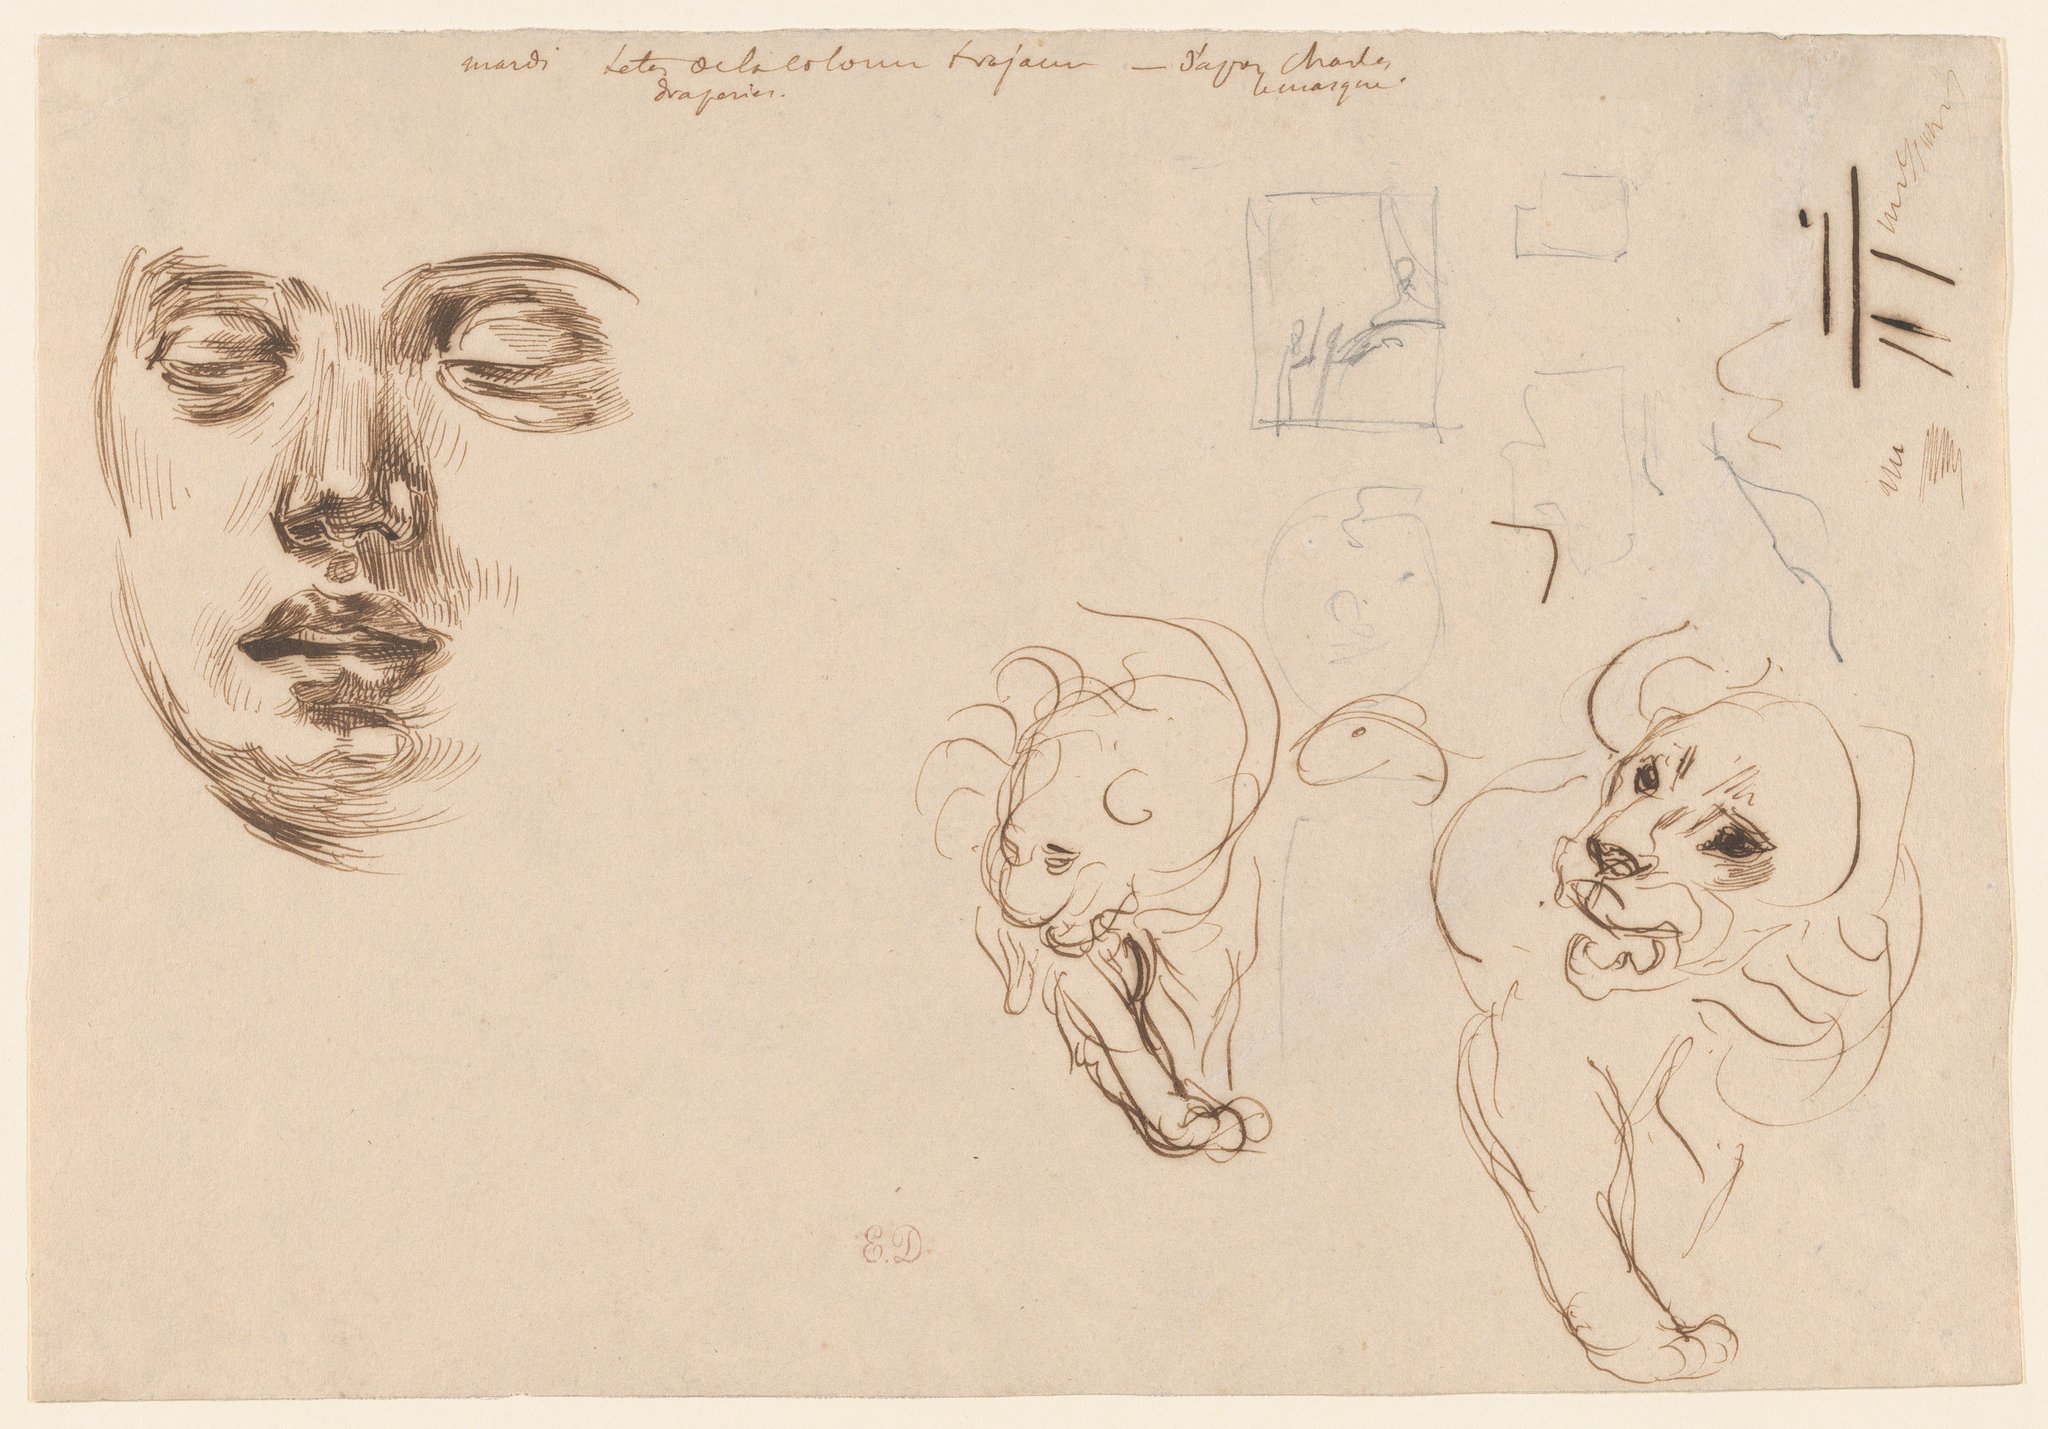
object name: drawing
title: Portrait of a Woman with Eyes Lowered; Two Sketches of Lions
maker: eugène delacroix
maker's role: artist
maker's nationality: french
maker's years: 1798-1863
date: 1821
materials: ink, iron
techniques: pen